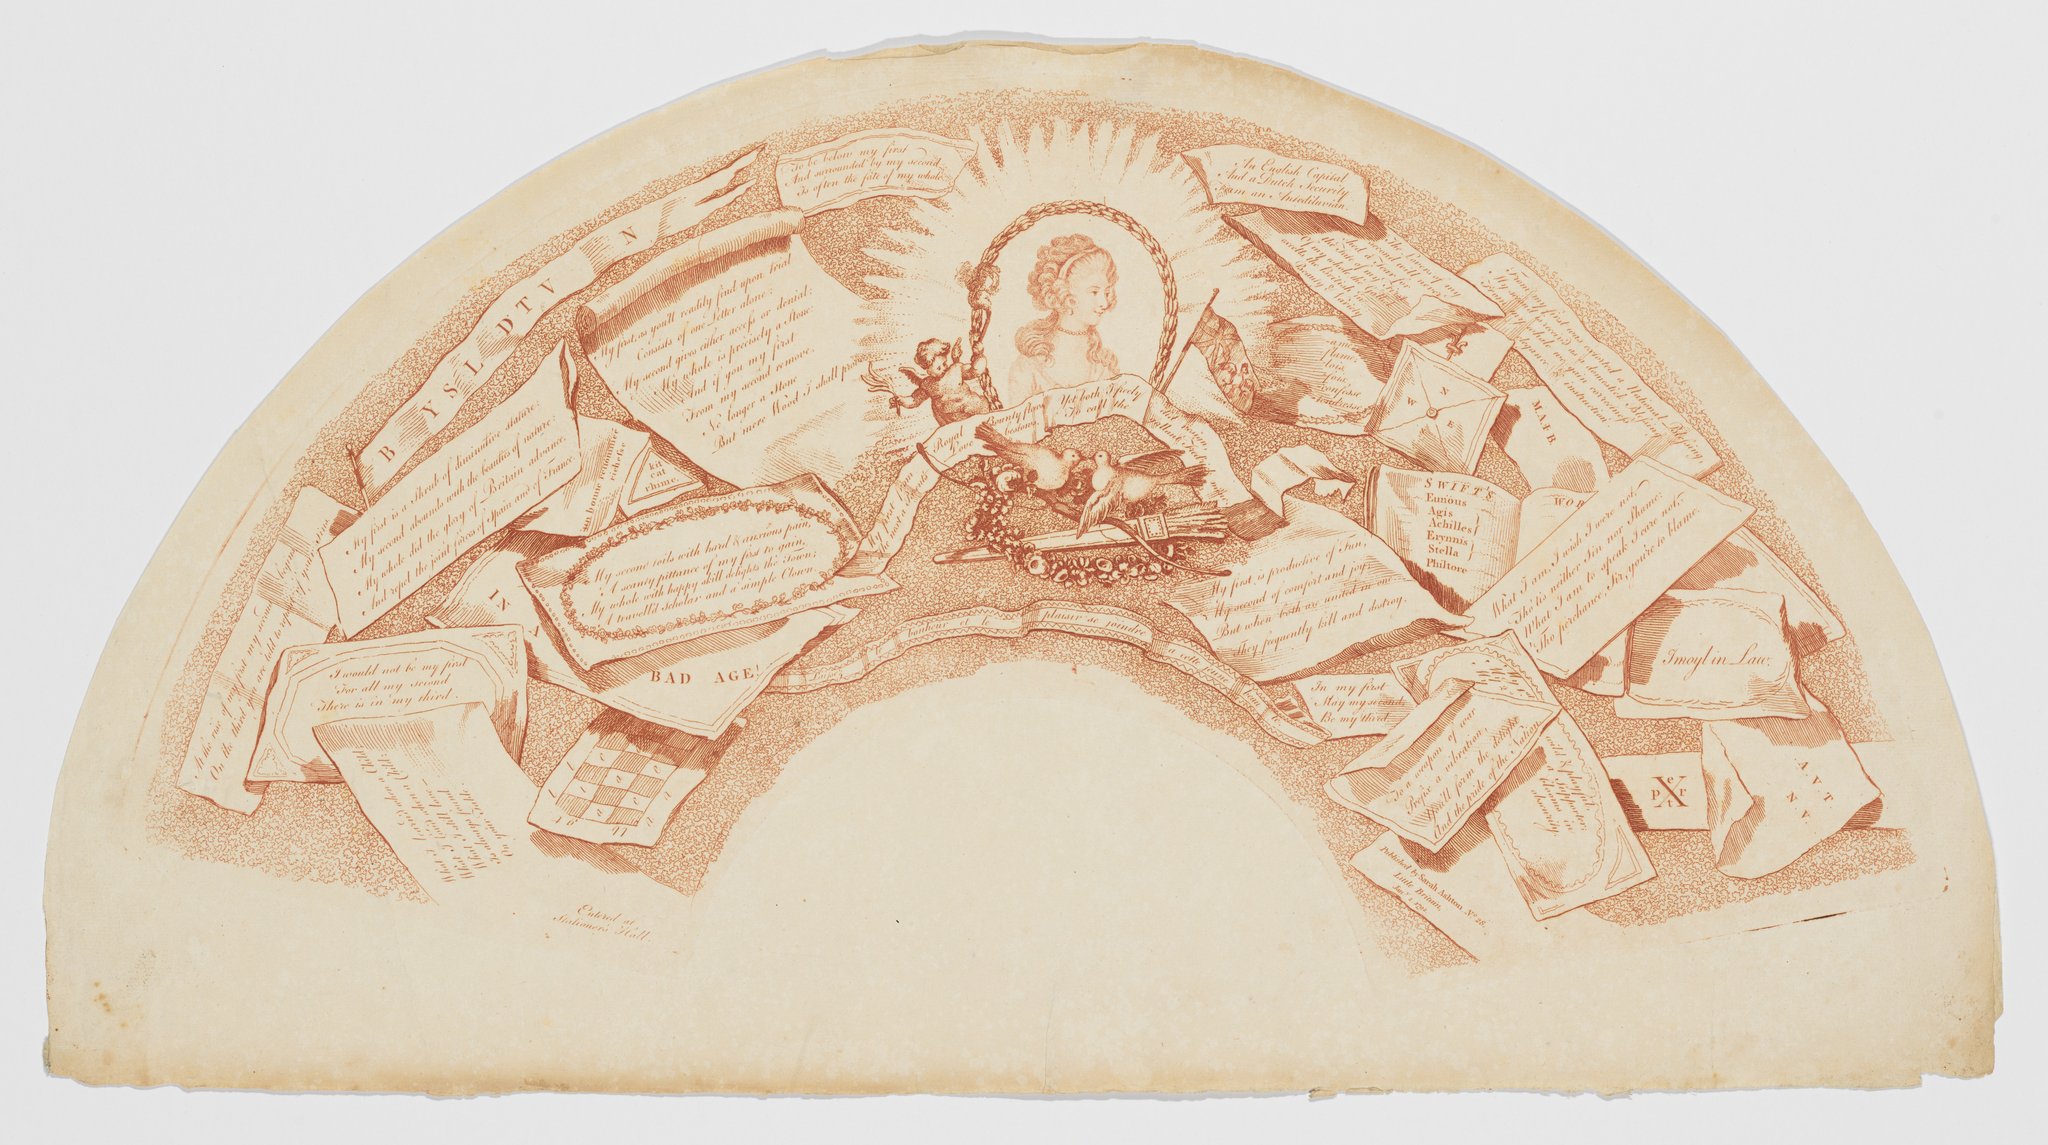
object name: print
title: Fan leaf celebrating the Duchess of York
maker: sarah ashton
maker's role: publisher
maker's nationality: british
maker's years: 1770-1798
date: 1792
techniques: etching, printing, engraving